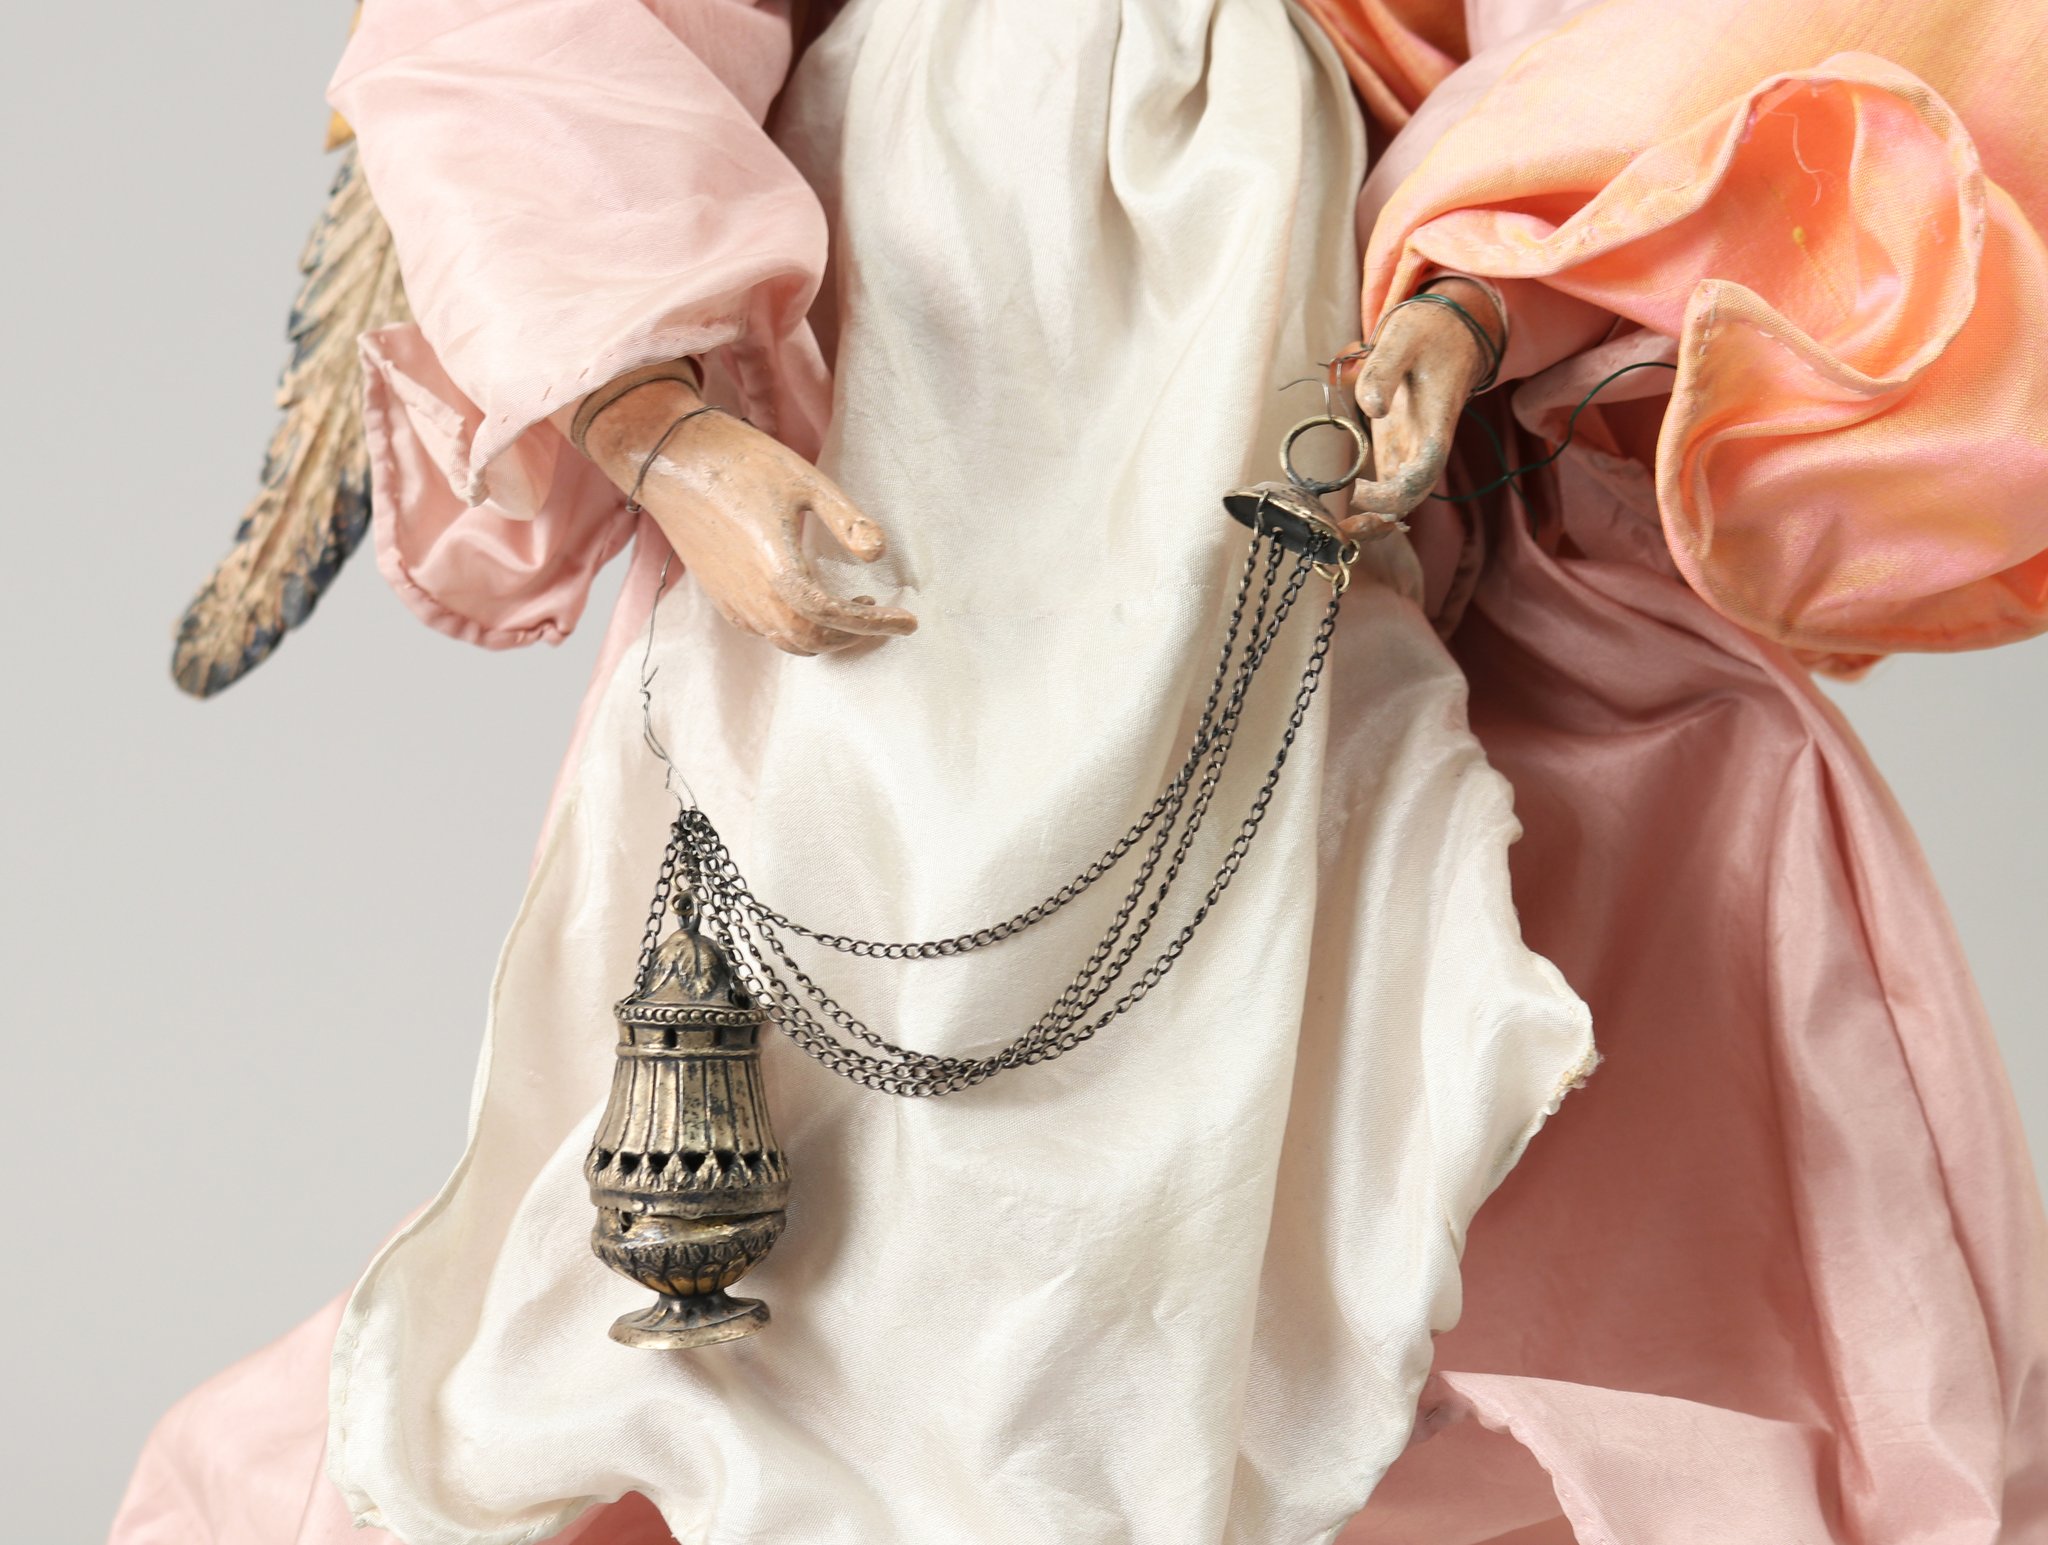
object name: crèche figure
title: Censer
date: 1751-1800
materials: silver gilt